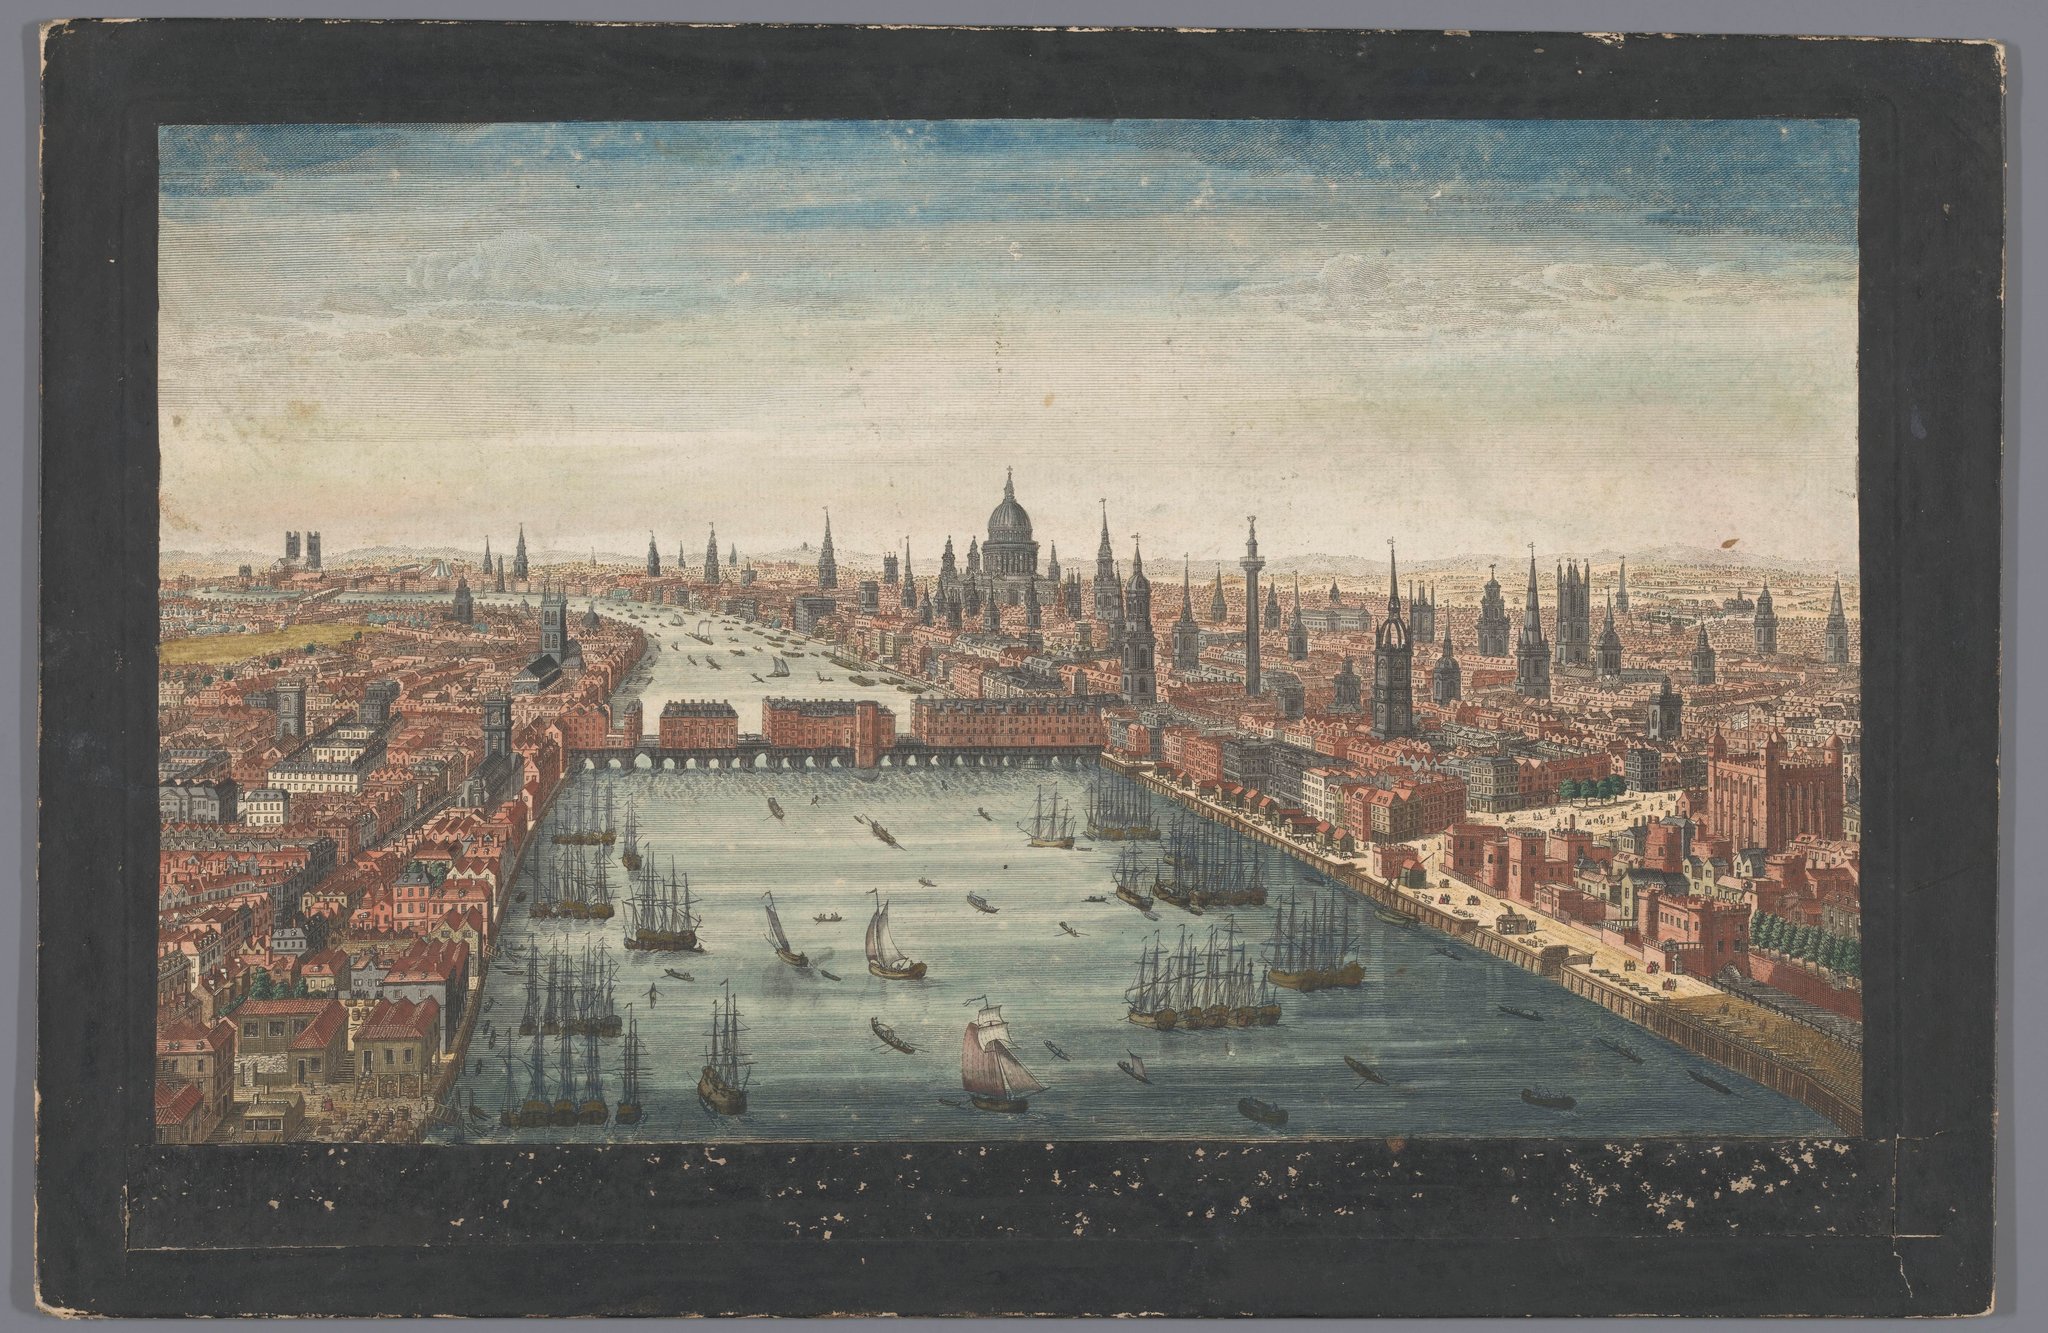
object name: print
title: Gezicht op de stad Londen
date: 1751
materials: cardboard, paper, watercolor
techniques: brush, etching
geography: london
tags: bridge in city across river, canal, etc. (+ city(-scape) with figures, staffage), sailing-ship, sailing-boat, church (exterior), city-view in general; 'veduta' (+ city(-scape) with figures, staffage), westminster abbey, london, thames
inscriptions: collector's mark: Lugt 2233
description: In het midden een bebouwde brug over de rivier de Theems en Saint Paul's Cathedral. Op de achtergrond links Westminster Abbey.